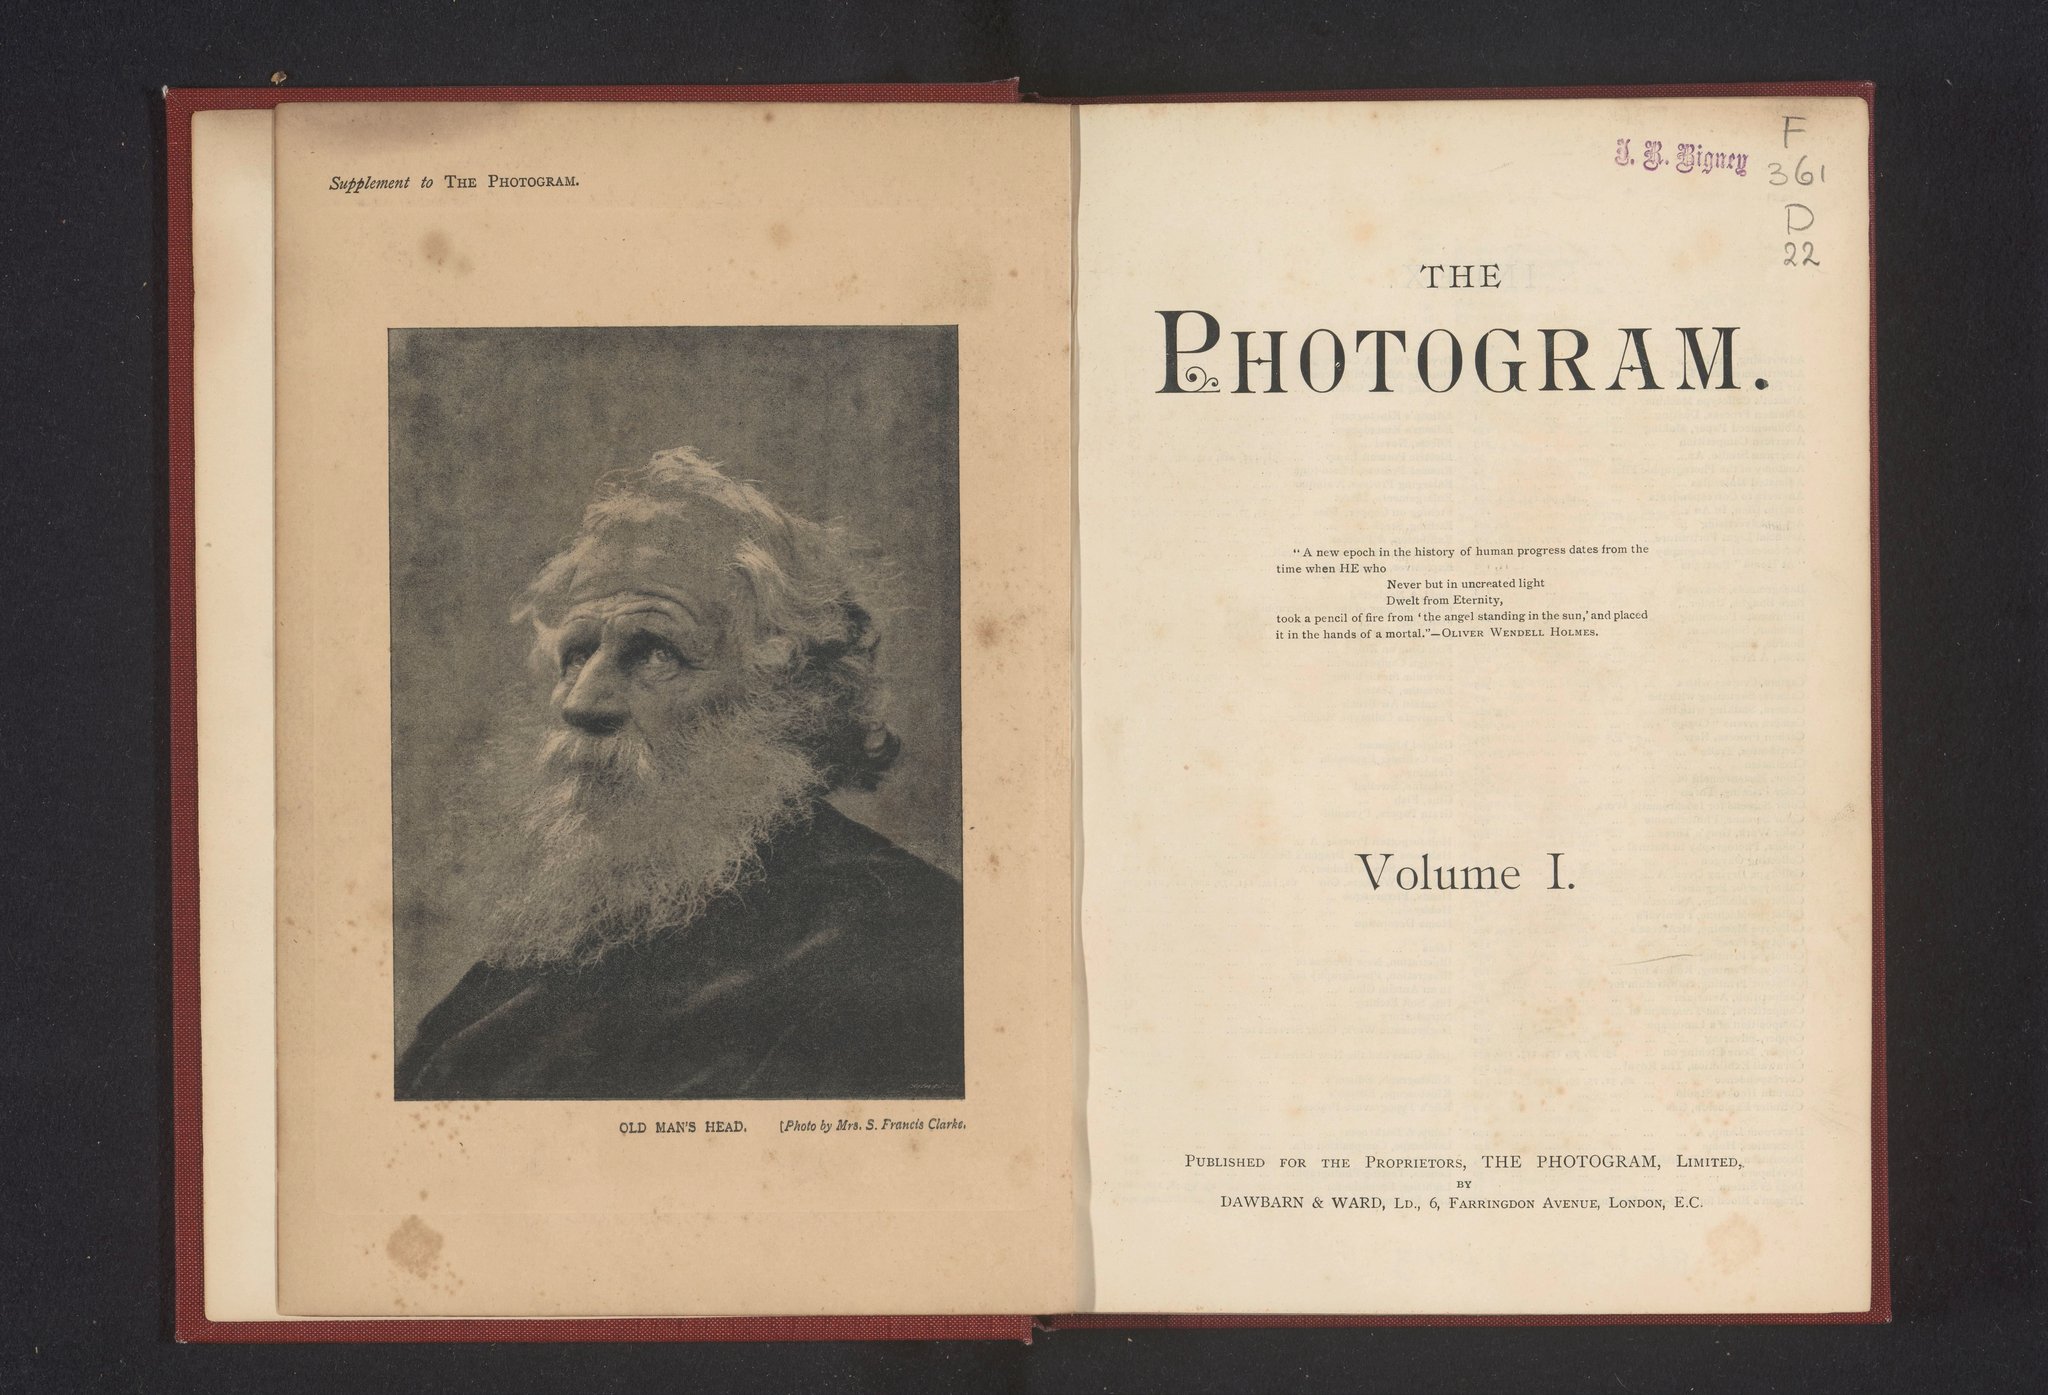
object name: magazine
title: The Photogram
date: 1894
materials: linen, paper, photographic support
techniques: albumen print, gelatin silver print, printing, engraving, woodburytype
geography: london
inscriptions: collector's mark: ‘J. R. Rigney’, date: ‘Oct 1997’